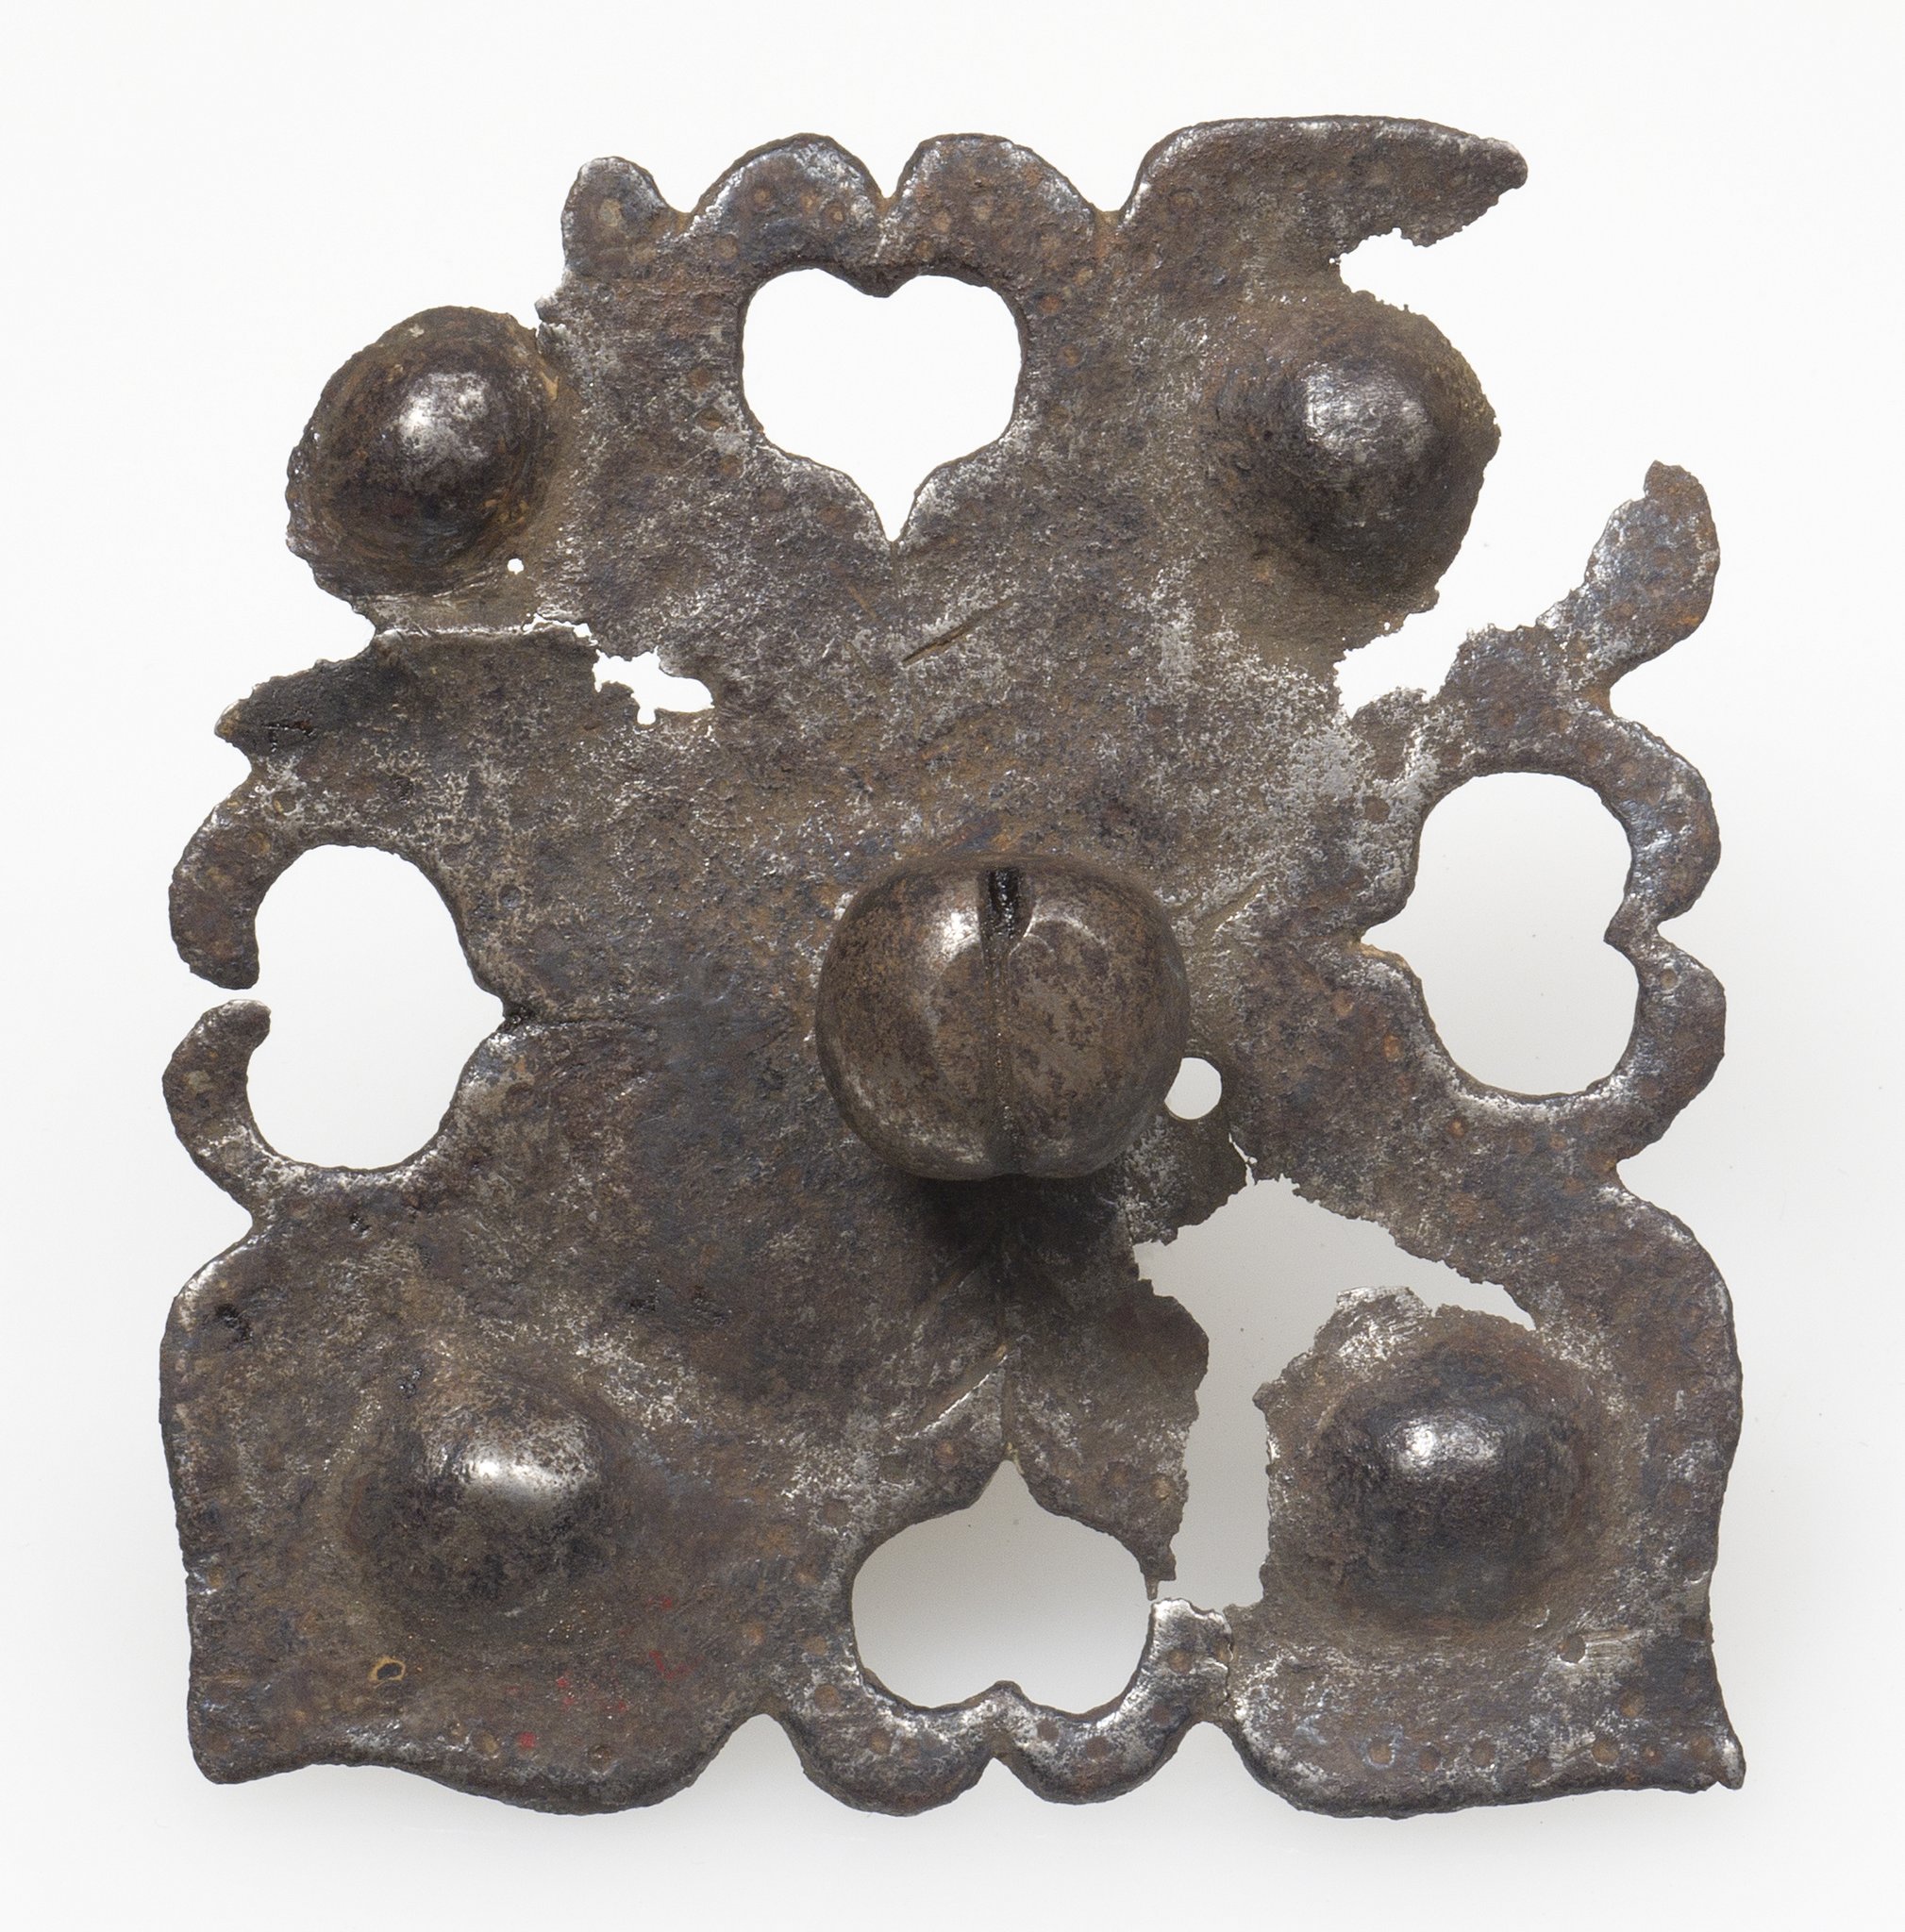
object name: plate and nail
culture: european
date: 1401-1600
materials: iron